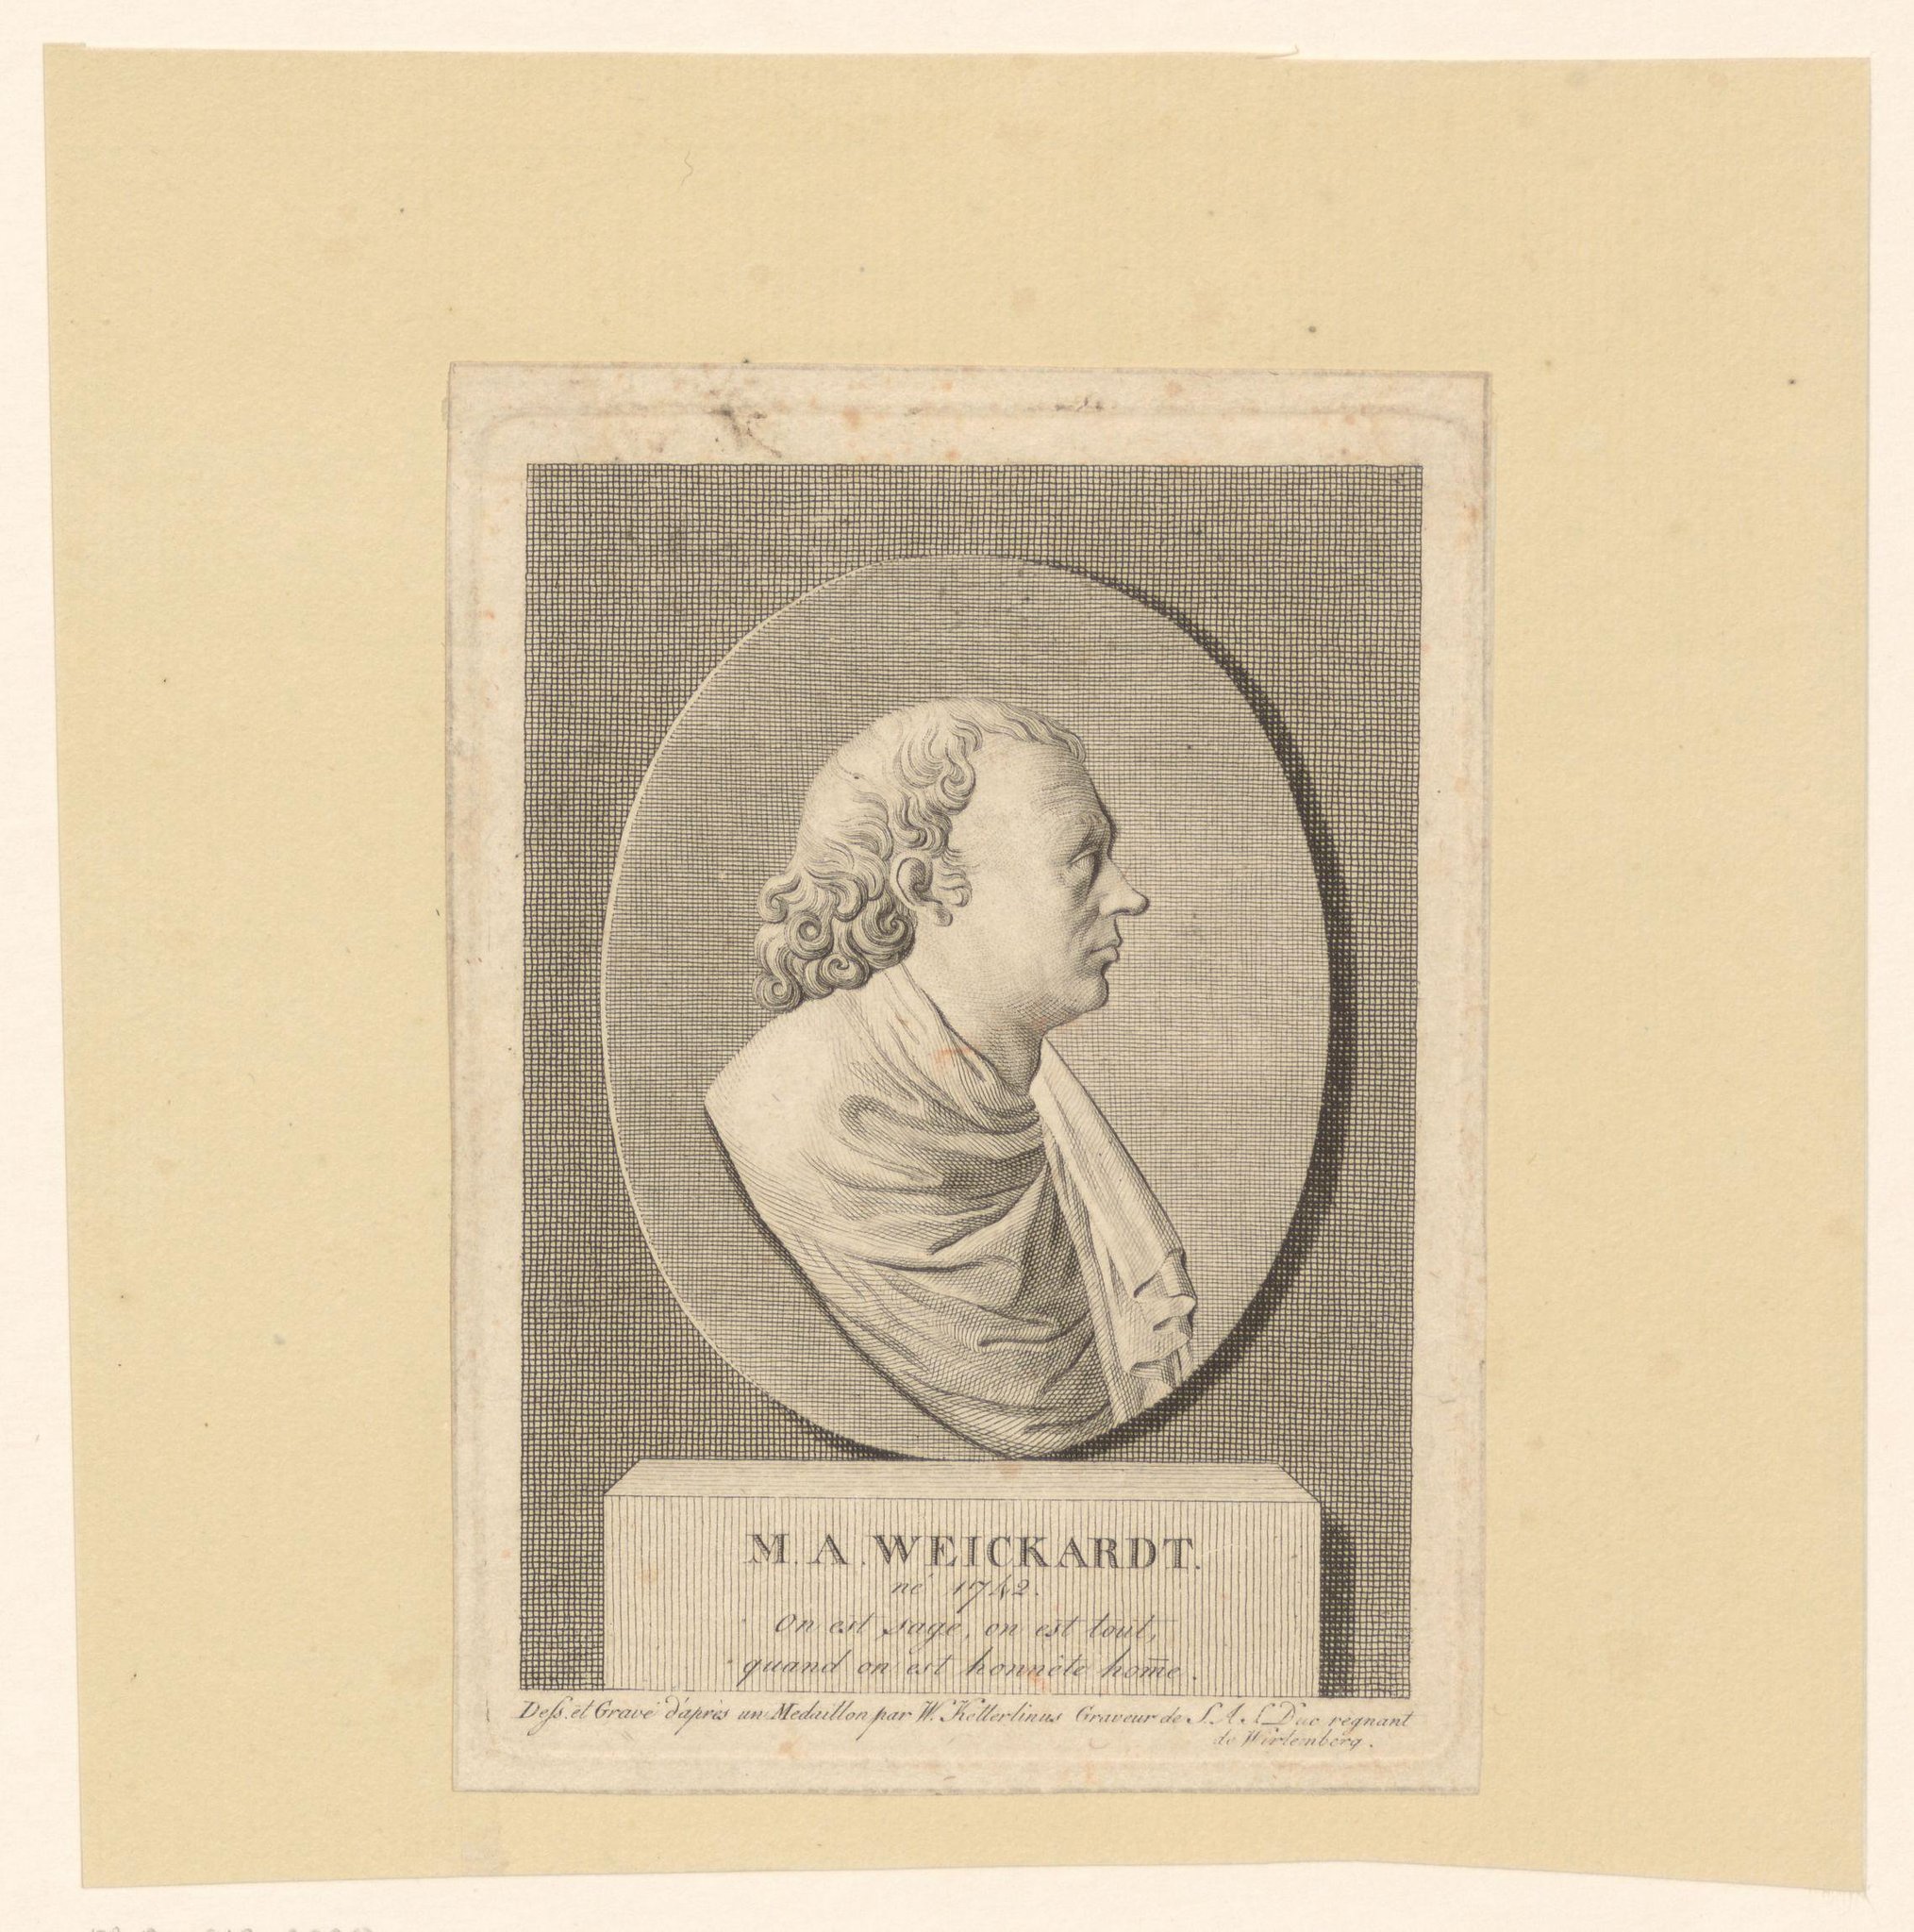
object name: print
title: Portret van Melchior Adam Weikard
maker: christian wilhelm ketterlin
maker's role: print maker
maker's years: 1766-1803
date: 1776-1803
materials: paper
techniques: engraving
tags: scholar, philosopher, historical persons, physician, doctor (+ portrait of scholar, scientist)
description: Borstbeeld in medaillon en profil. Tekst in het Latijn op de sokkel onderaan.